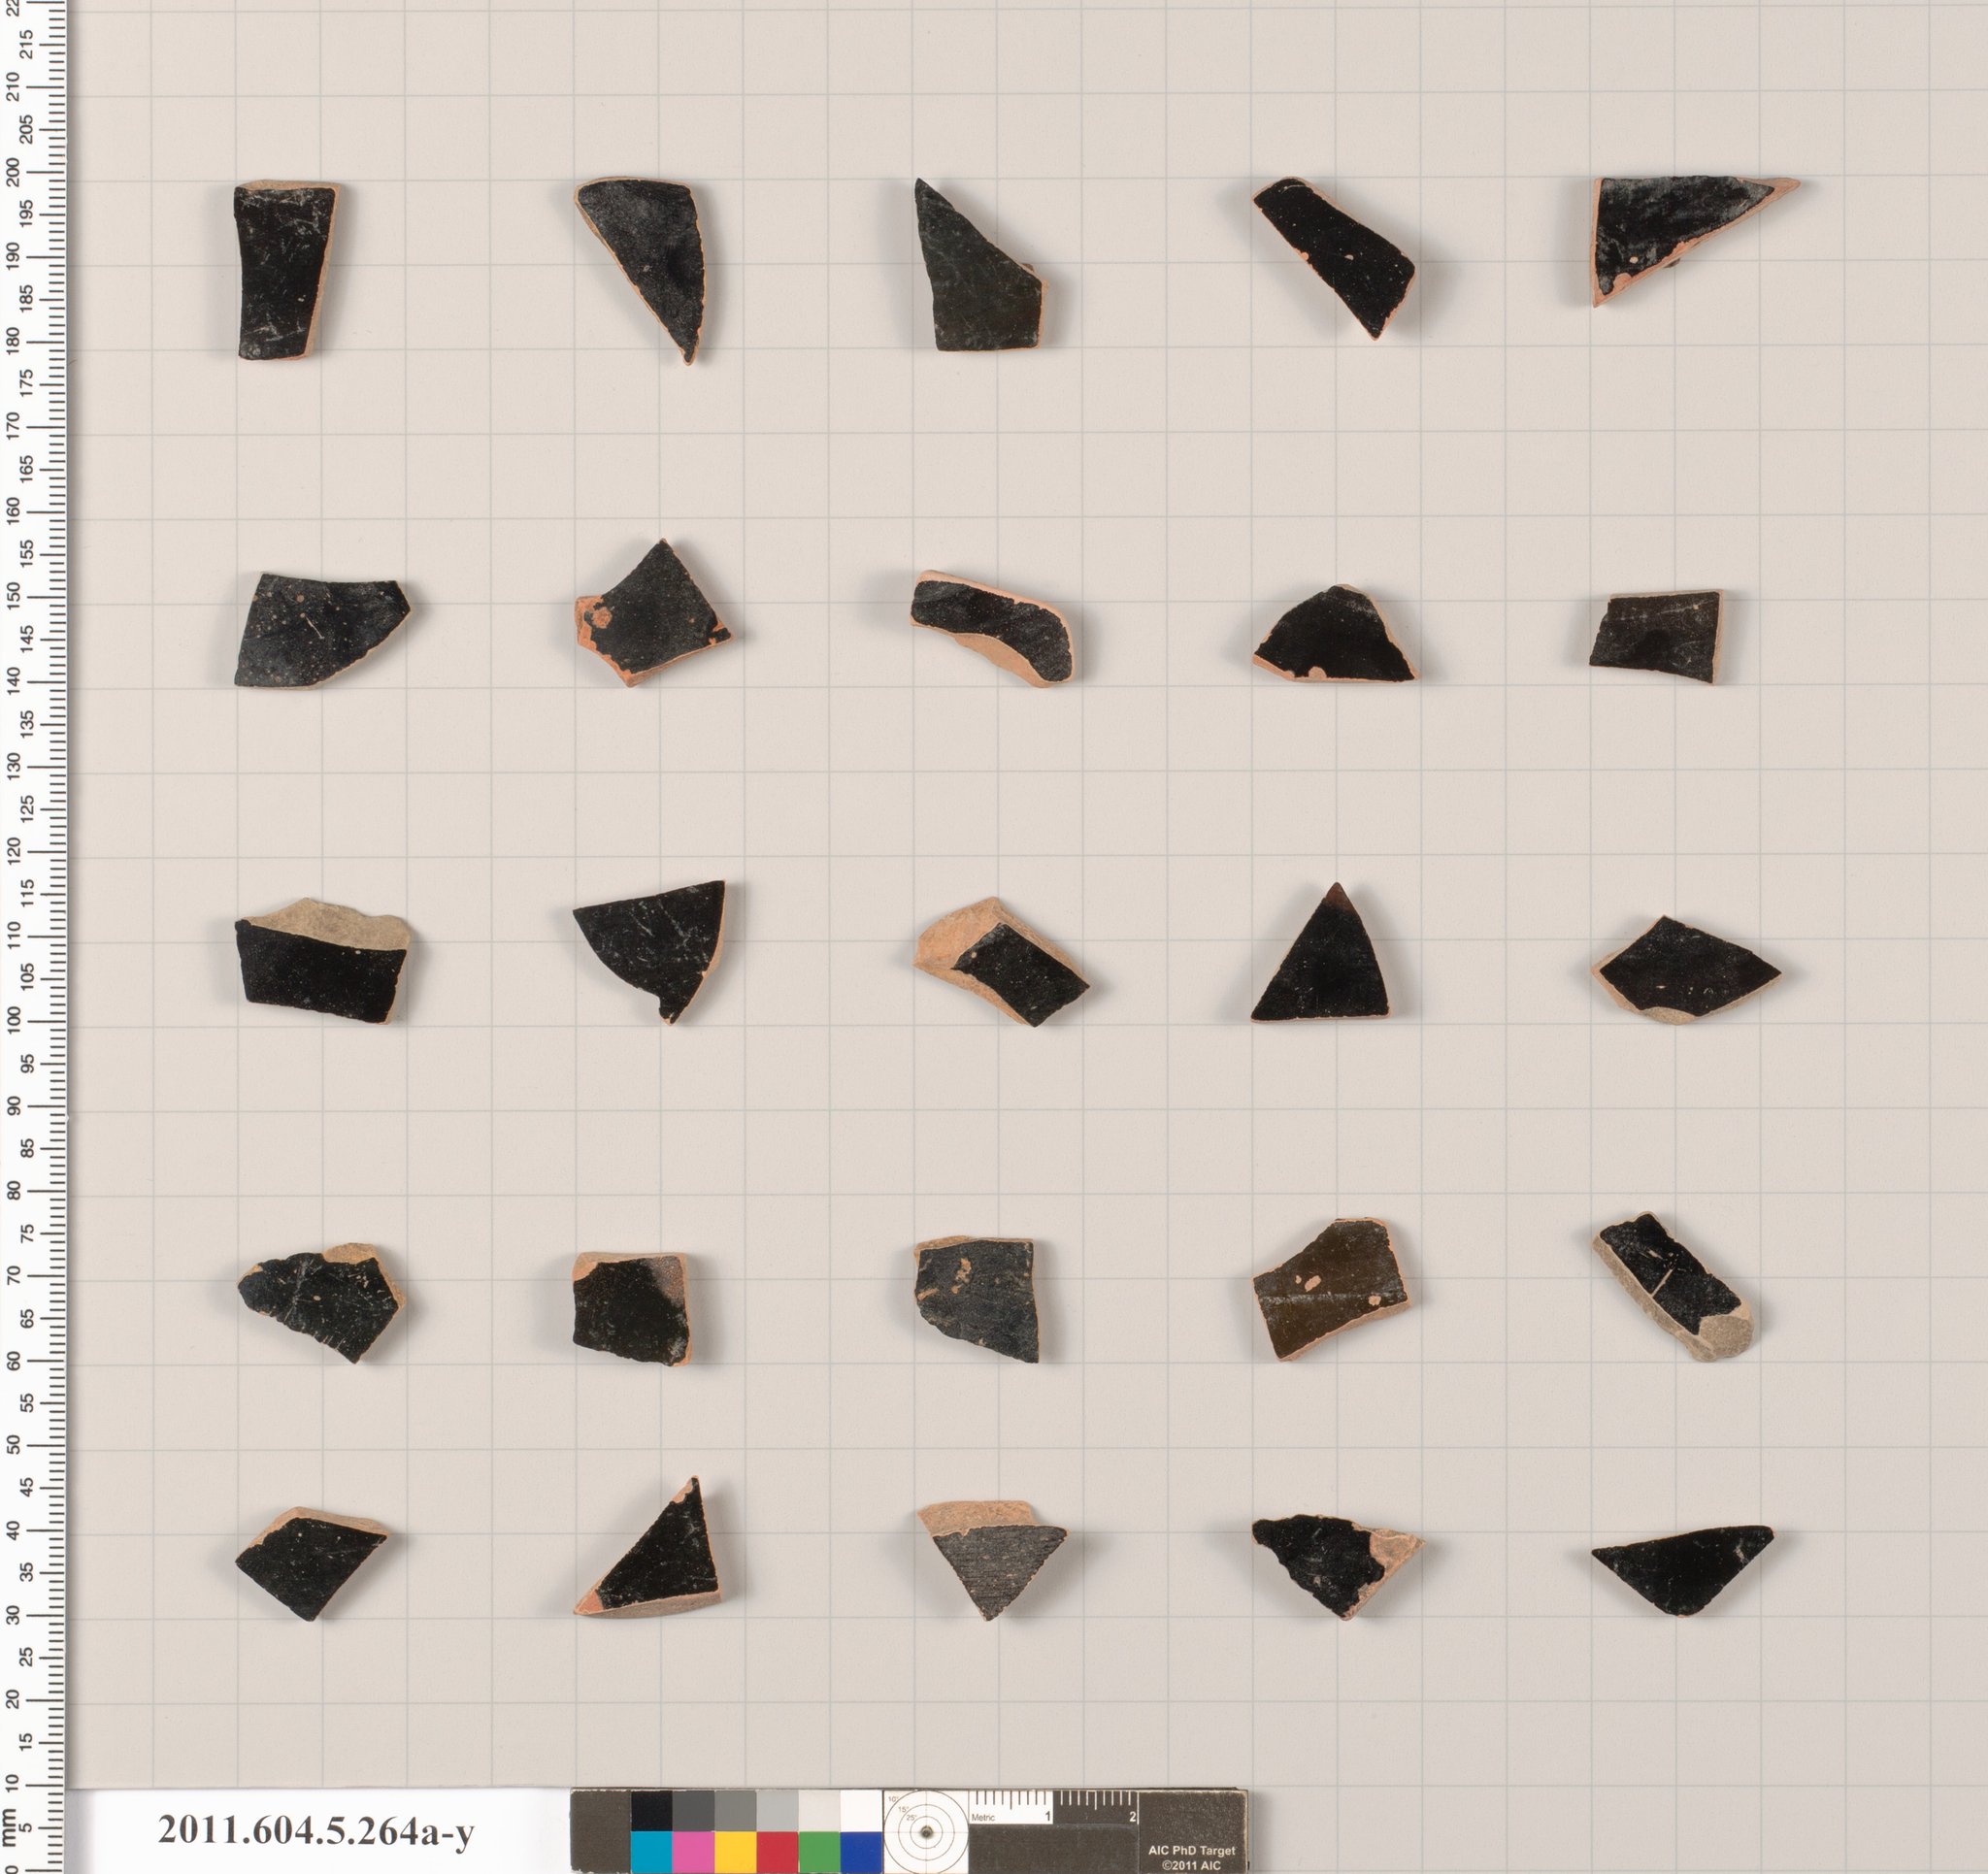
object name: kylix fragment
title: Terracotta fragments of kylikes (drinking cups)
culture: greek, attic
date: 600-401 BCE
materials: terracotta